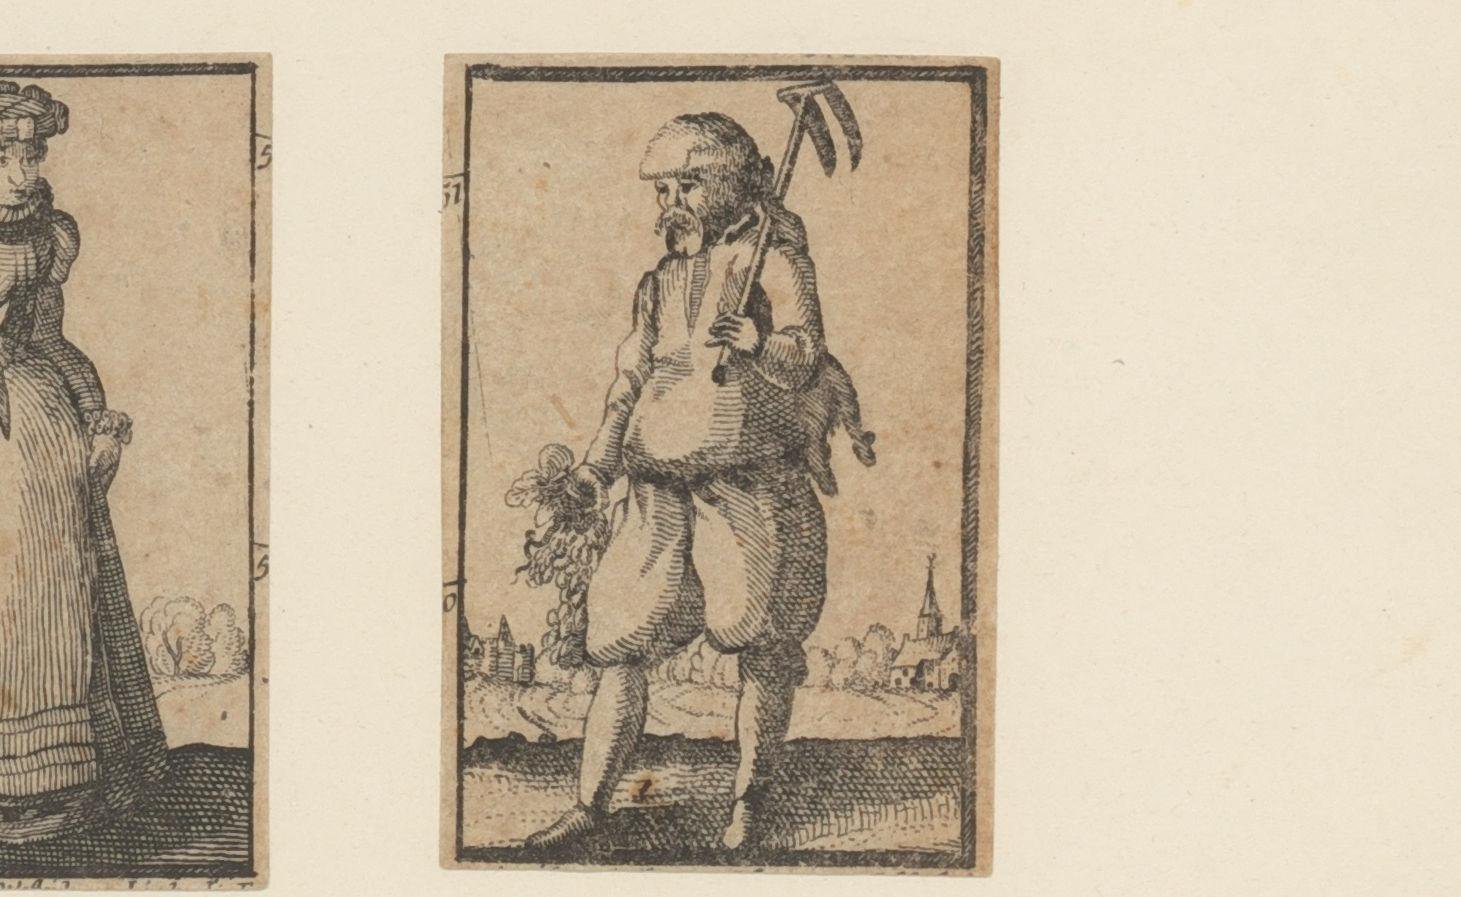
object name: print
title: Staande boer met werktuig in zijn hand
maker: Anonymous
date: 1600-1699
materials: paper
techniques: etching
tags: farmers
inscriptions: stamp, stamp, collector's mark: Lugt 1641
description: Onderwerpsrubrieken binnen de Atlas Zeden en Gewoonten: Zeden en Gewoonten in Engeren Zin, De Kleeding, Kleederdrachten (tijdvakken), De Spaansche tijd. (1550 – 1600).